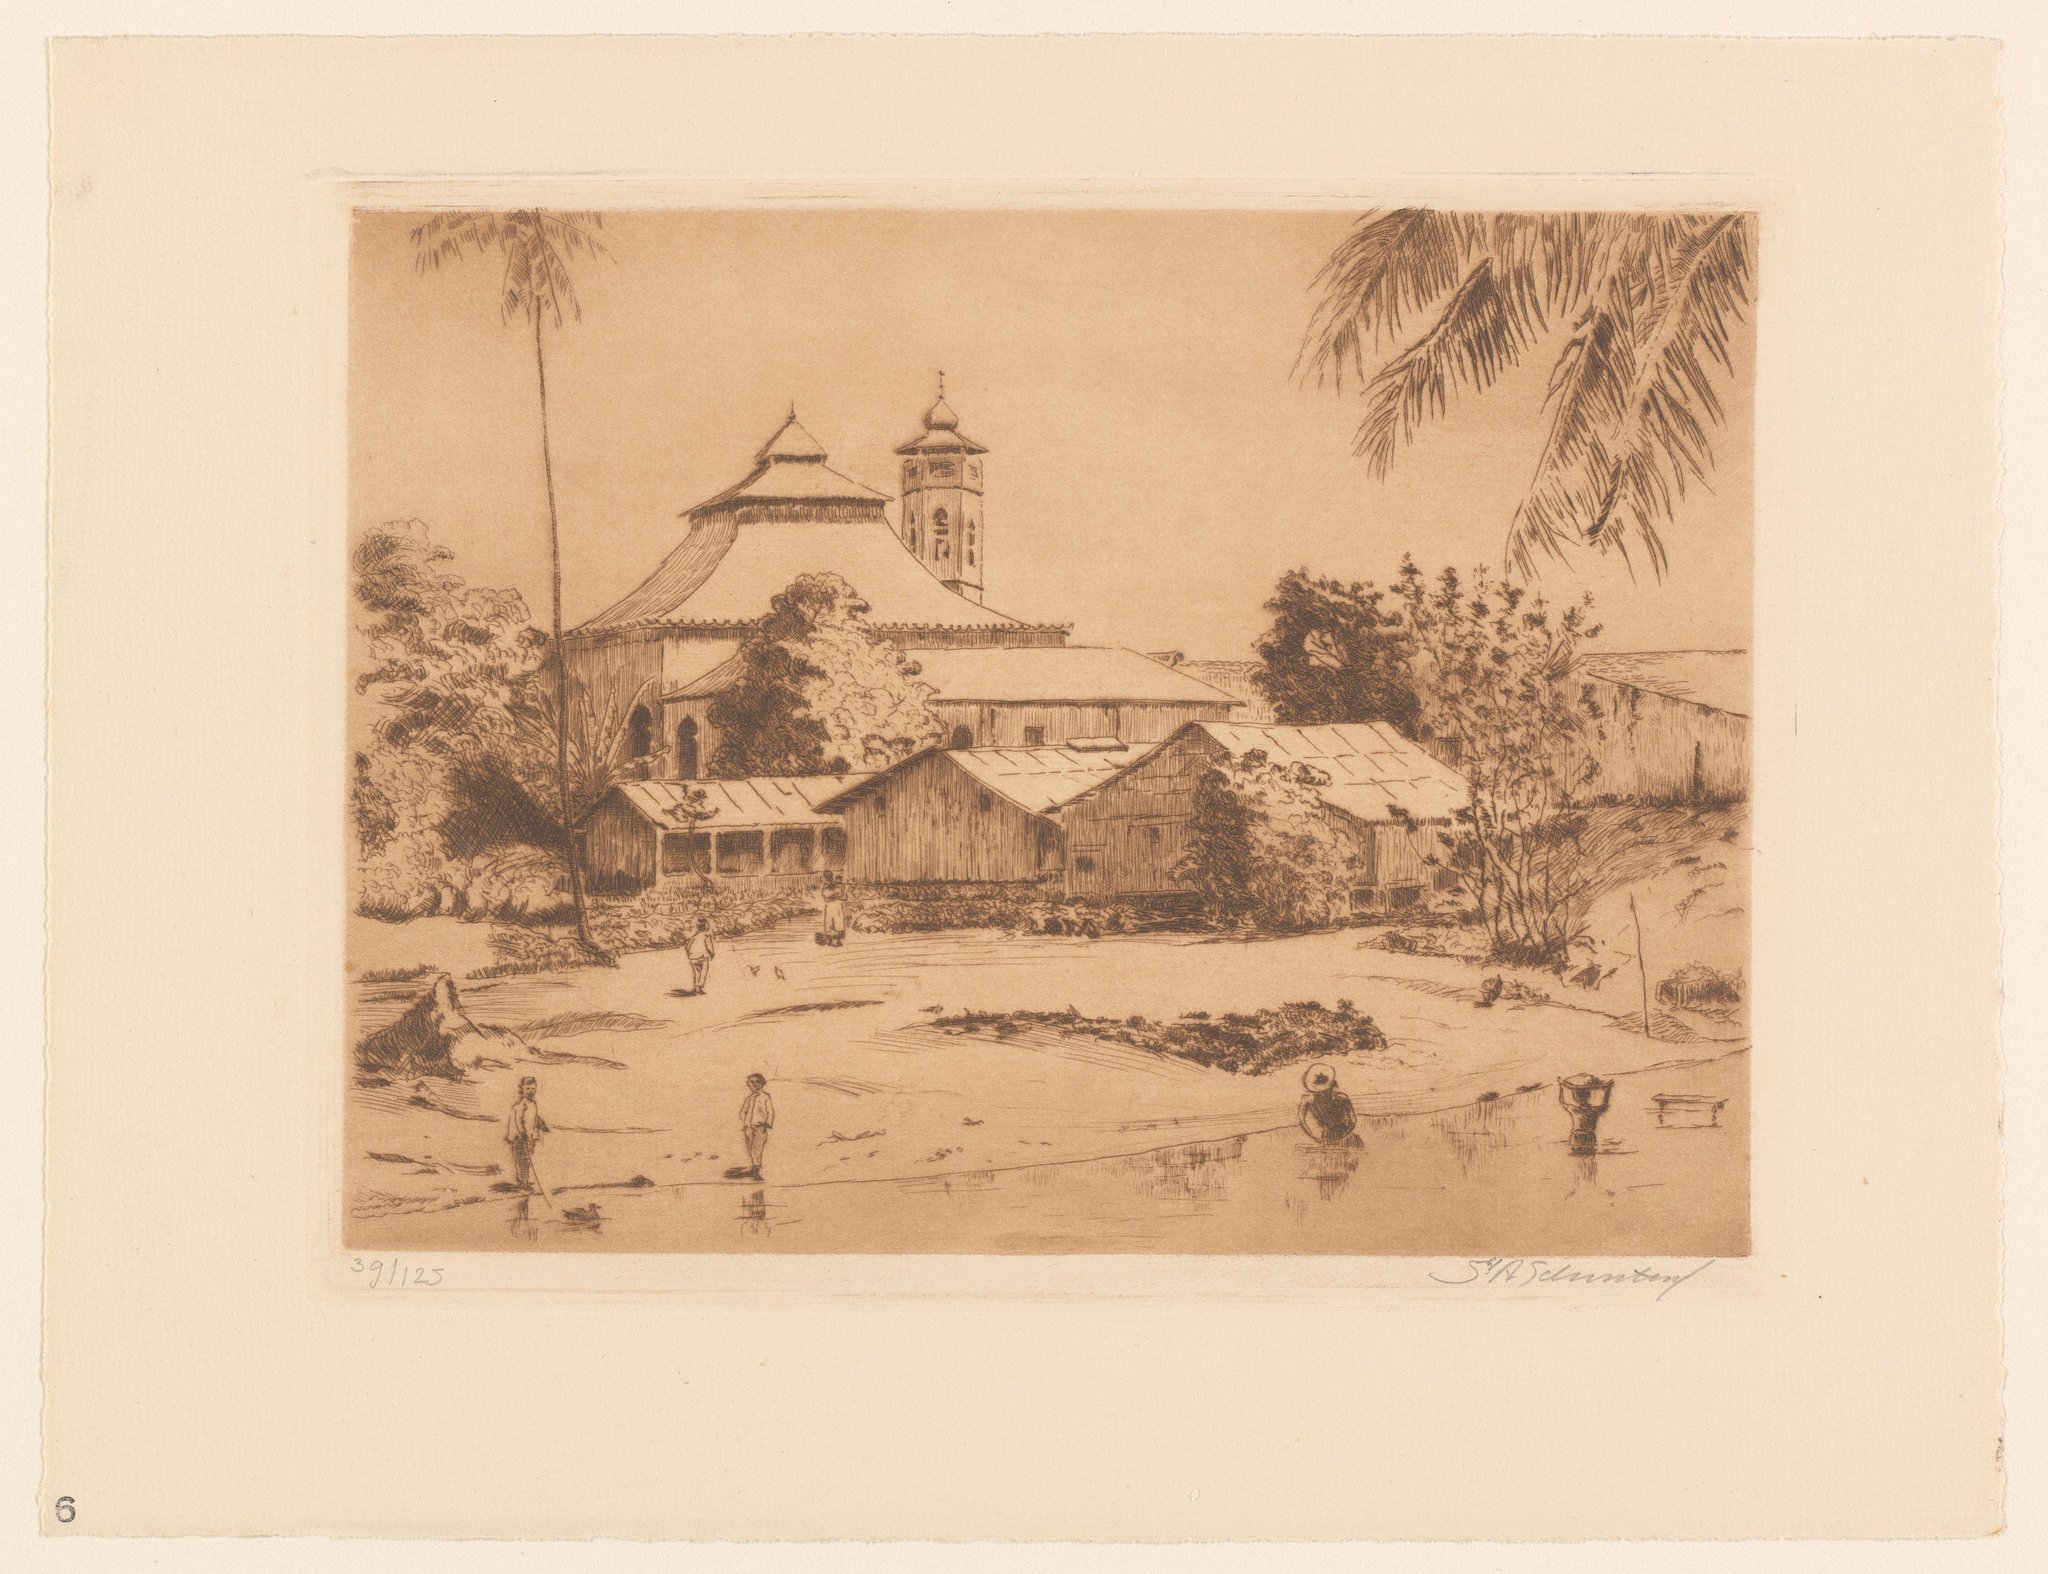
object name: print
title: Oude missigit, Medan. (Gezien van de achterzijde)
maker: st. a. schouten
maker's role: print maker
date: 1929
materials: paper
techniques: etching, intaglio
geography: amsterdam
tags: temple, shrine ~ islam, mohammedanism, street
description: Aangezien geboorte- en sterfdatum van de kunstenaar onbekend zijn, is voor de rechtenbepaling van dit object de productiedatum gehanteerd.